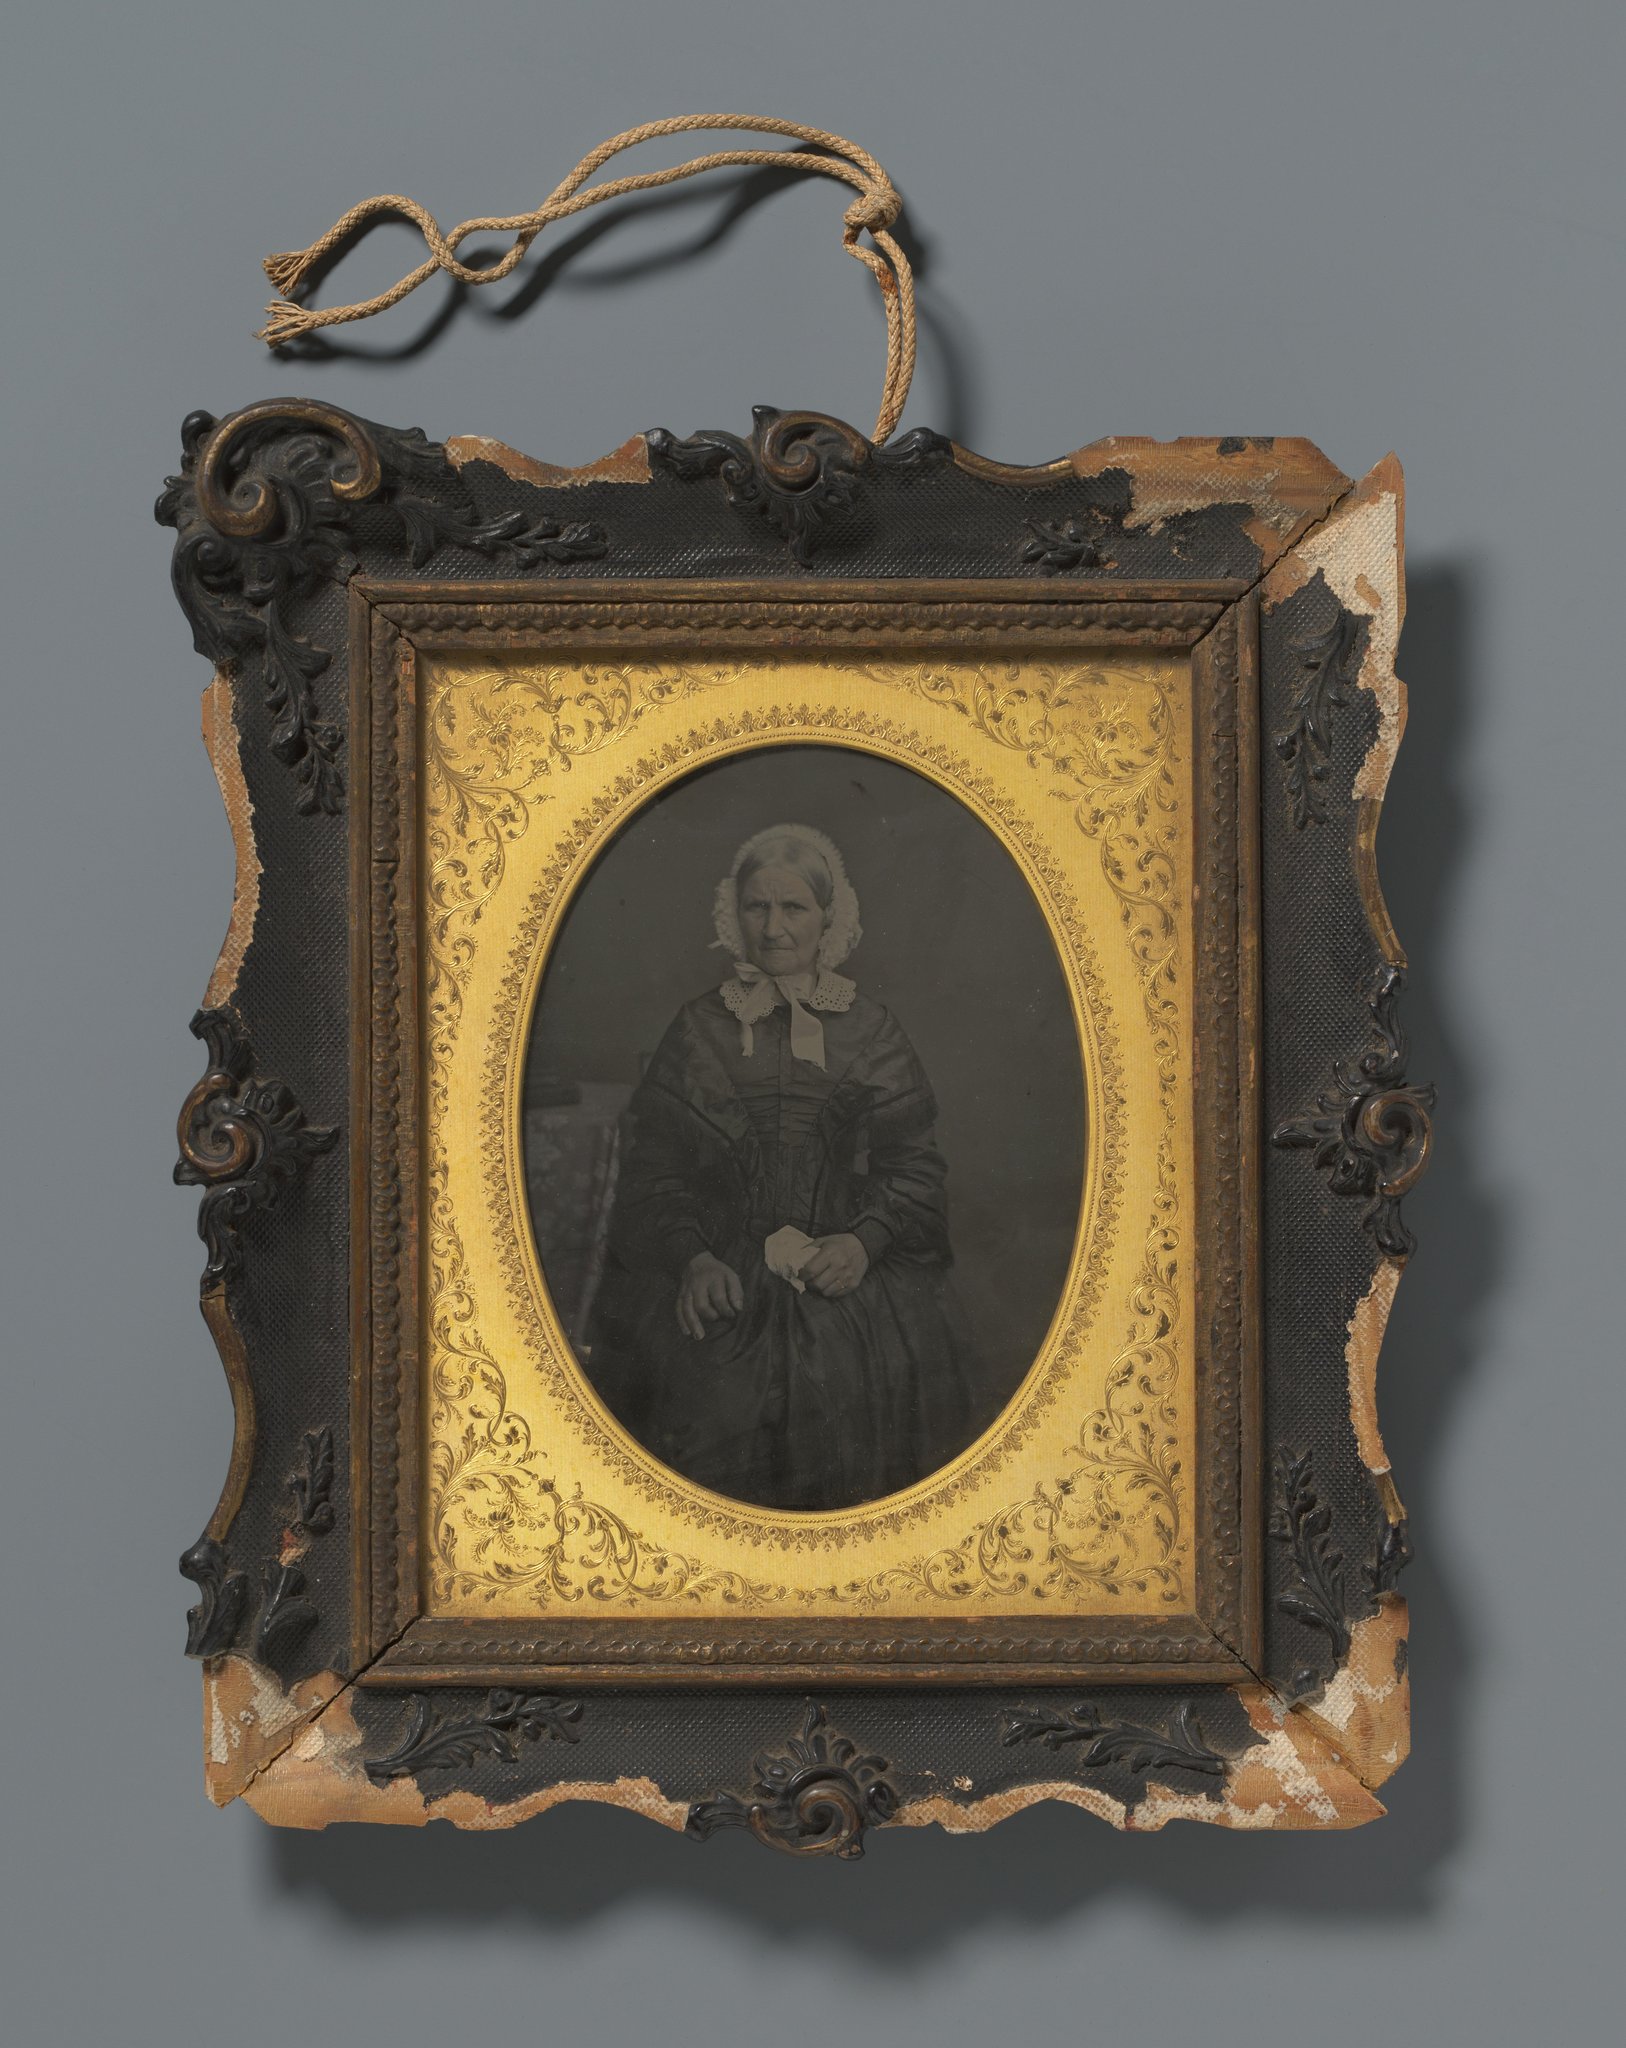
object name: photograph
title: Portret van een onbekende oude vrouw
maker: Anonymous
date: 1855-1870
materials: glass, metal, paper, fiber, wood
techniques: ambrotype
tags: anonymous historical person portrayed alone - bb - woman